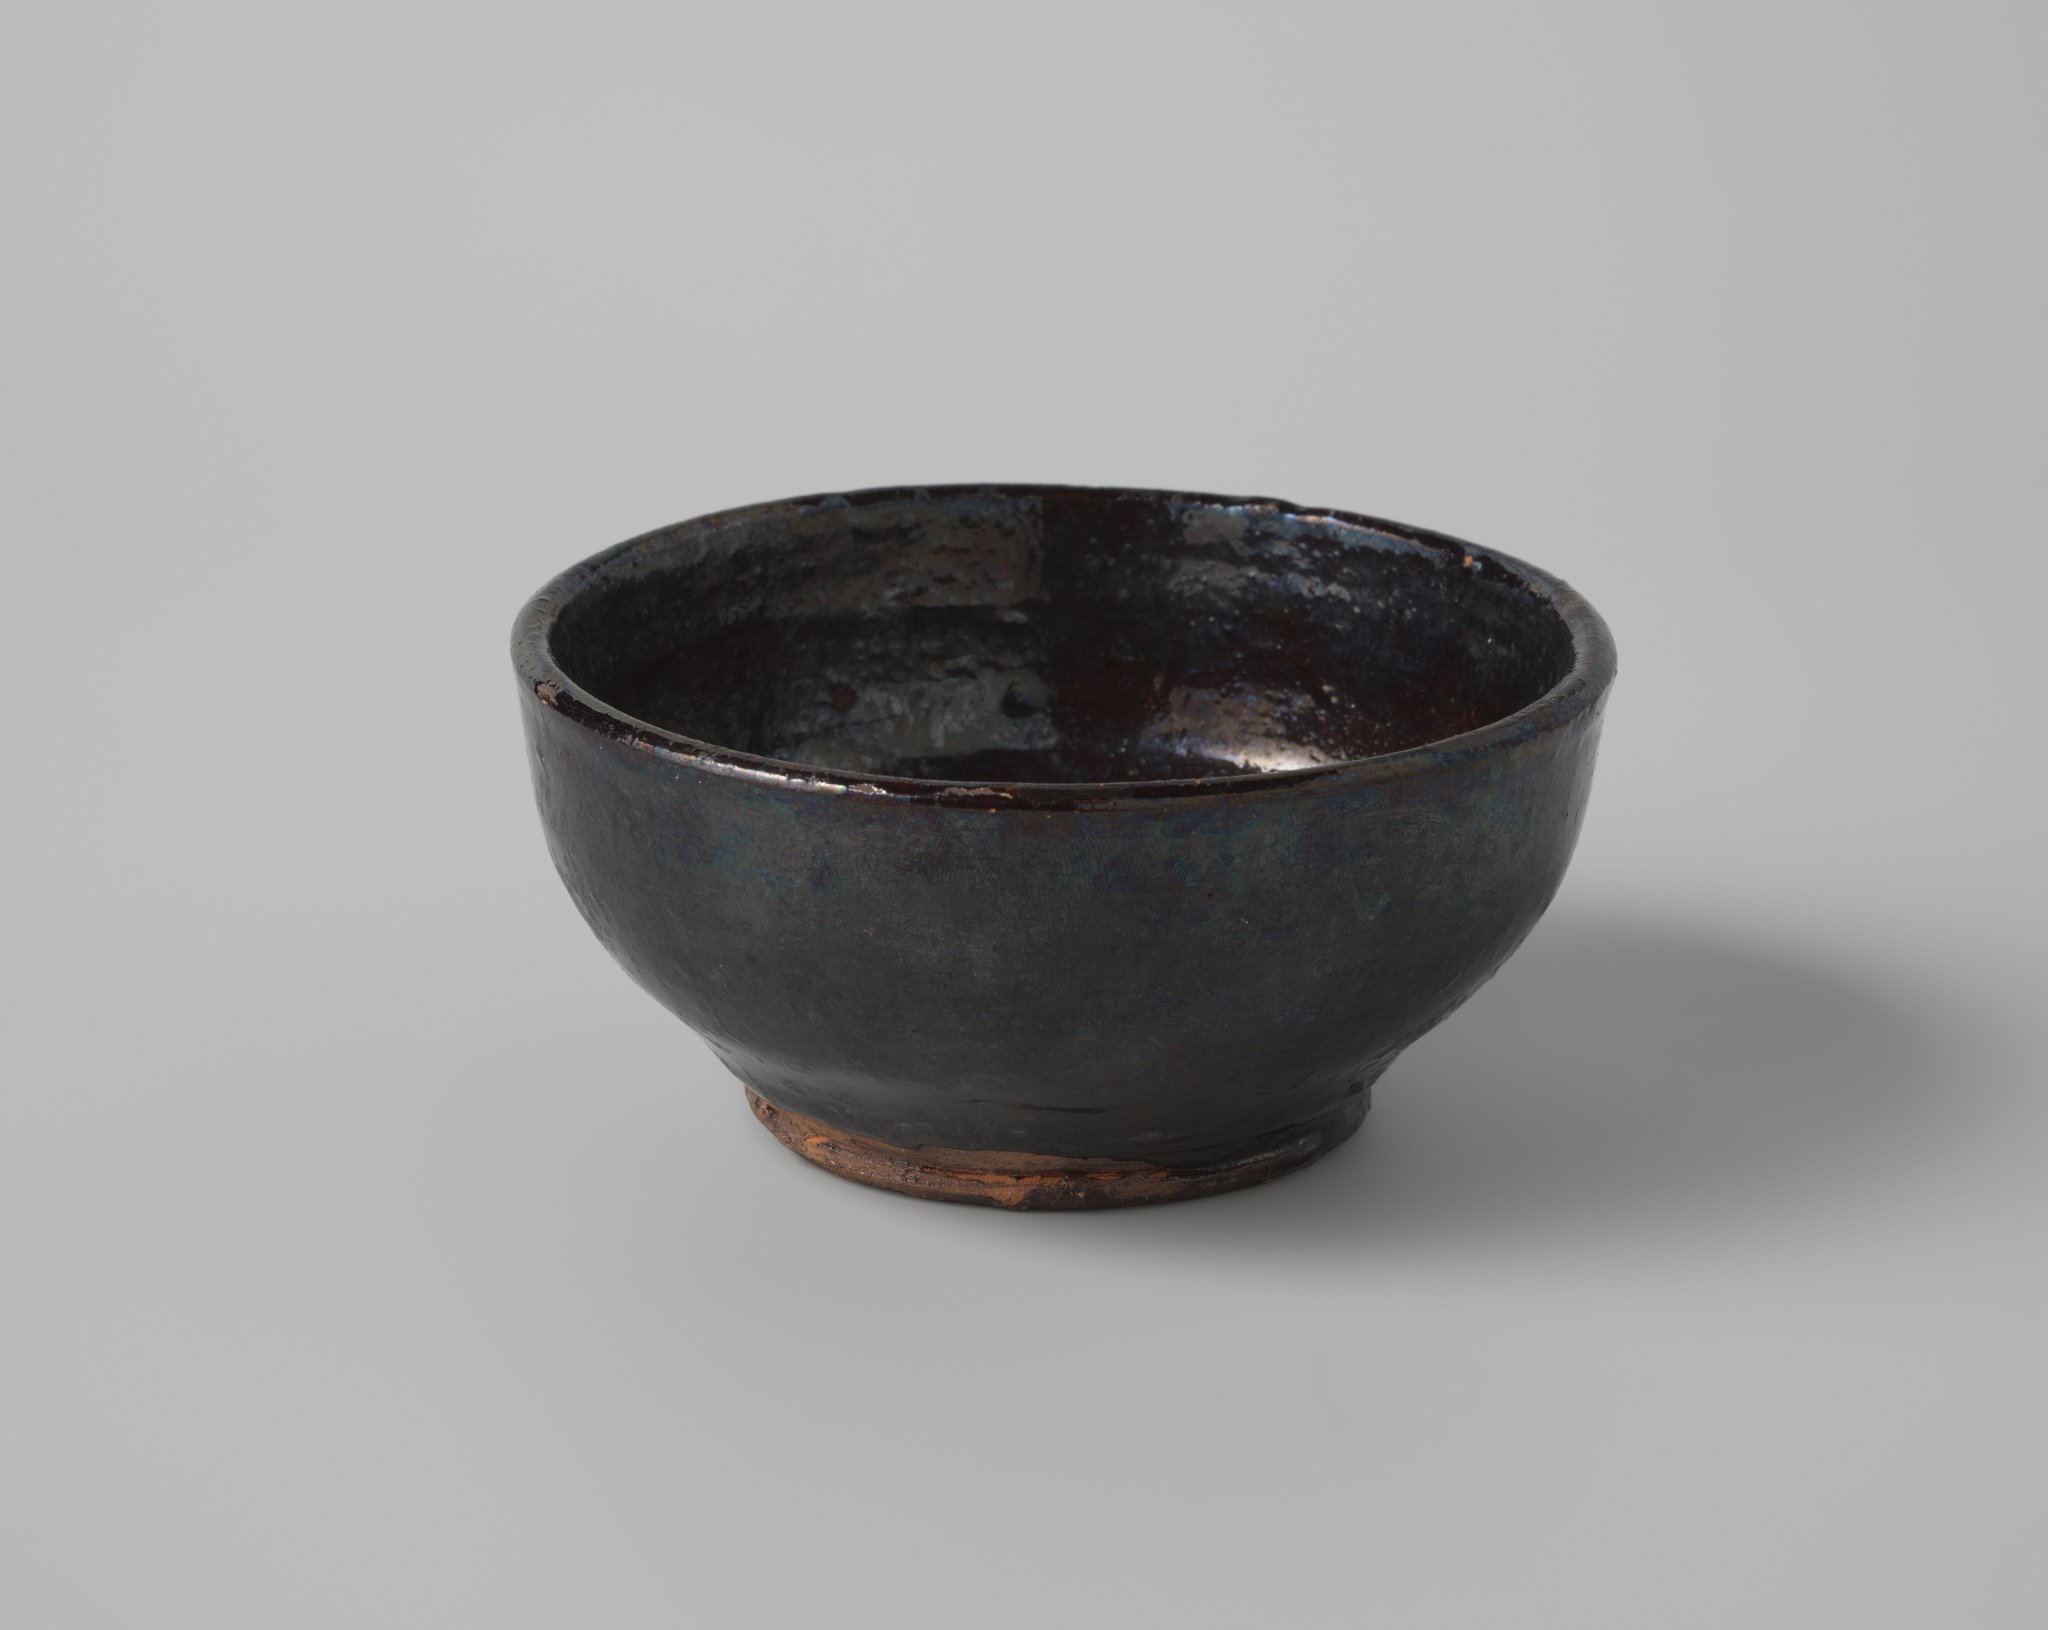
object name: bowl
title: Koffiekom van loodglazuuraardewerk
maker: Anonymous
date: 1870-1880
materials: earthenware, glaze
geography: tegelen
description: Deksel, die tevens als kopje kan dienen, heeft twee staande oren en is afgeplat conisch. Opmerking: Behoort bij (koffiekan) inv. nr. BK-NM-12452.